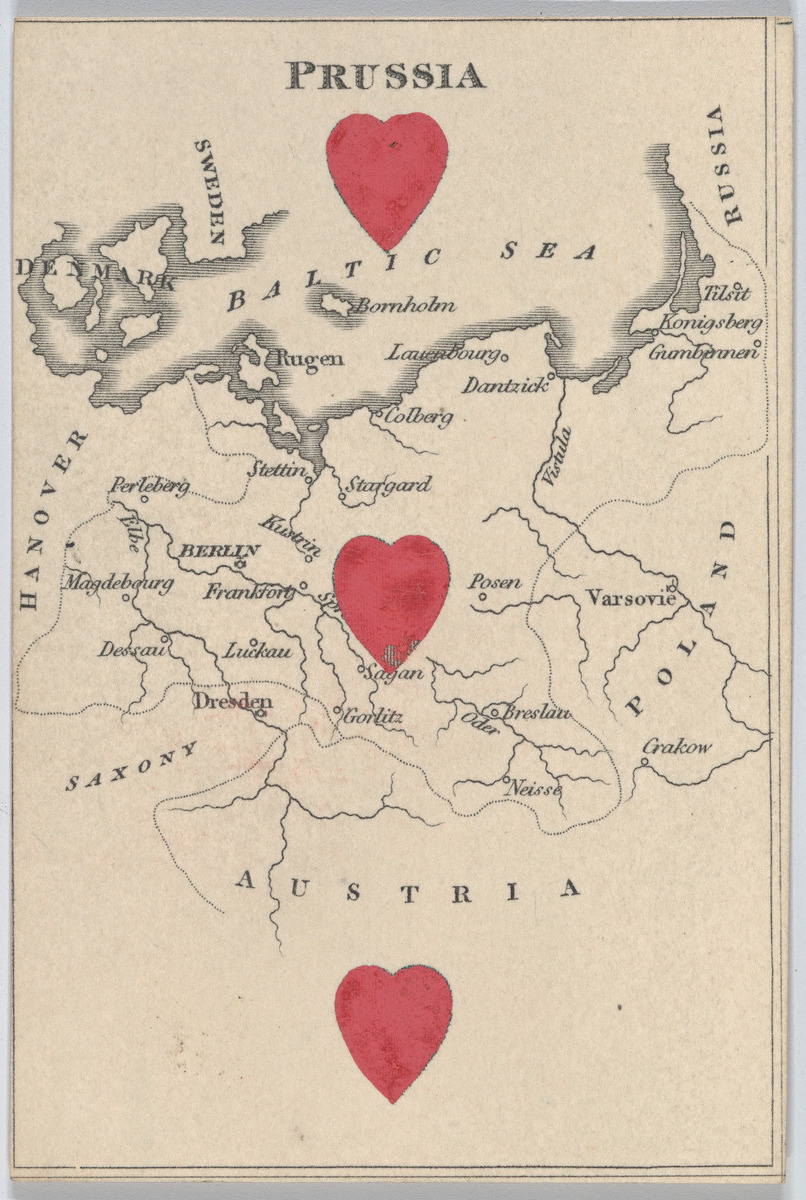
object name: print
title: Prussia, from "Court Game of Geography"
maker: william and henry rock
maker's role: publisher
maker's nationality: british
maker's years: 1821-1884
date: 1838-1855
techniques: engraving, hand coloring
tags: playing cards,maps